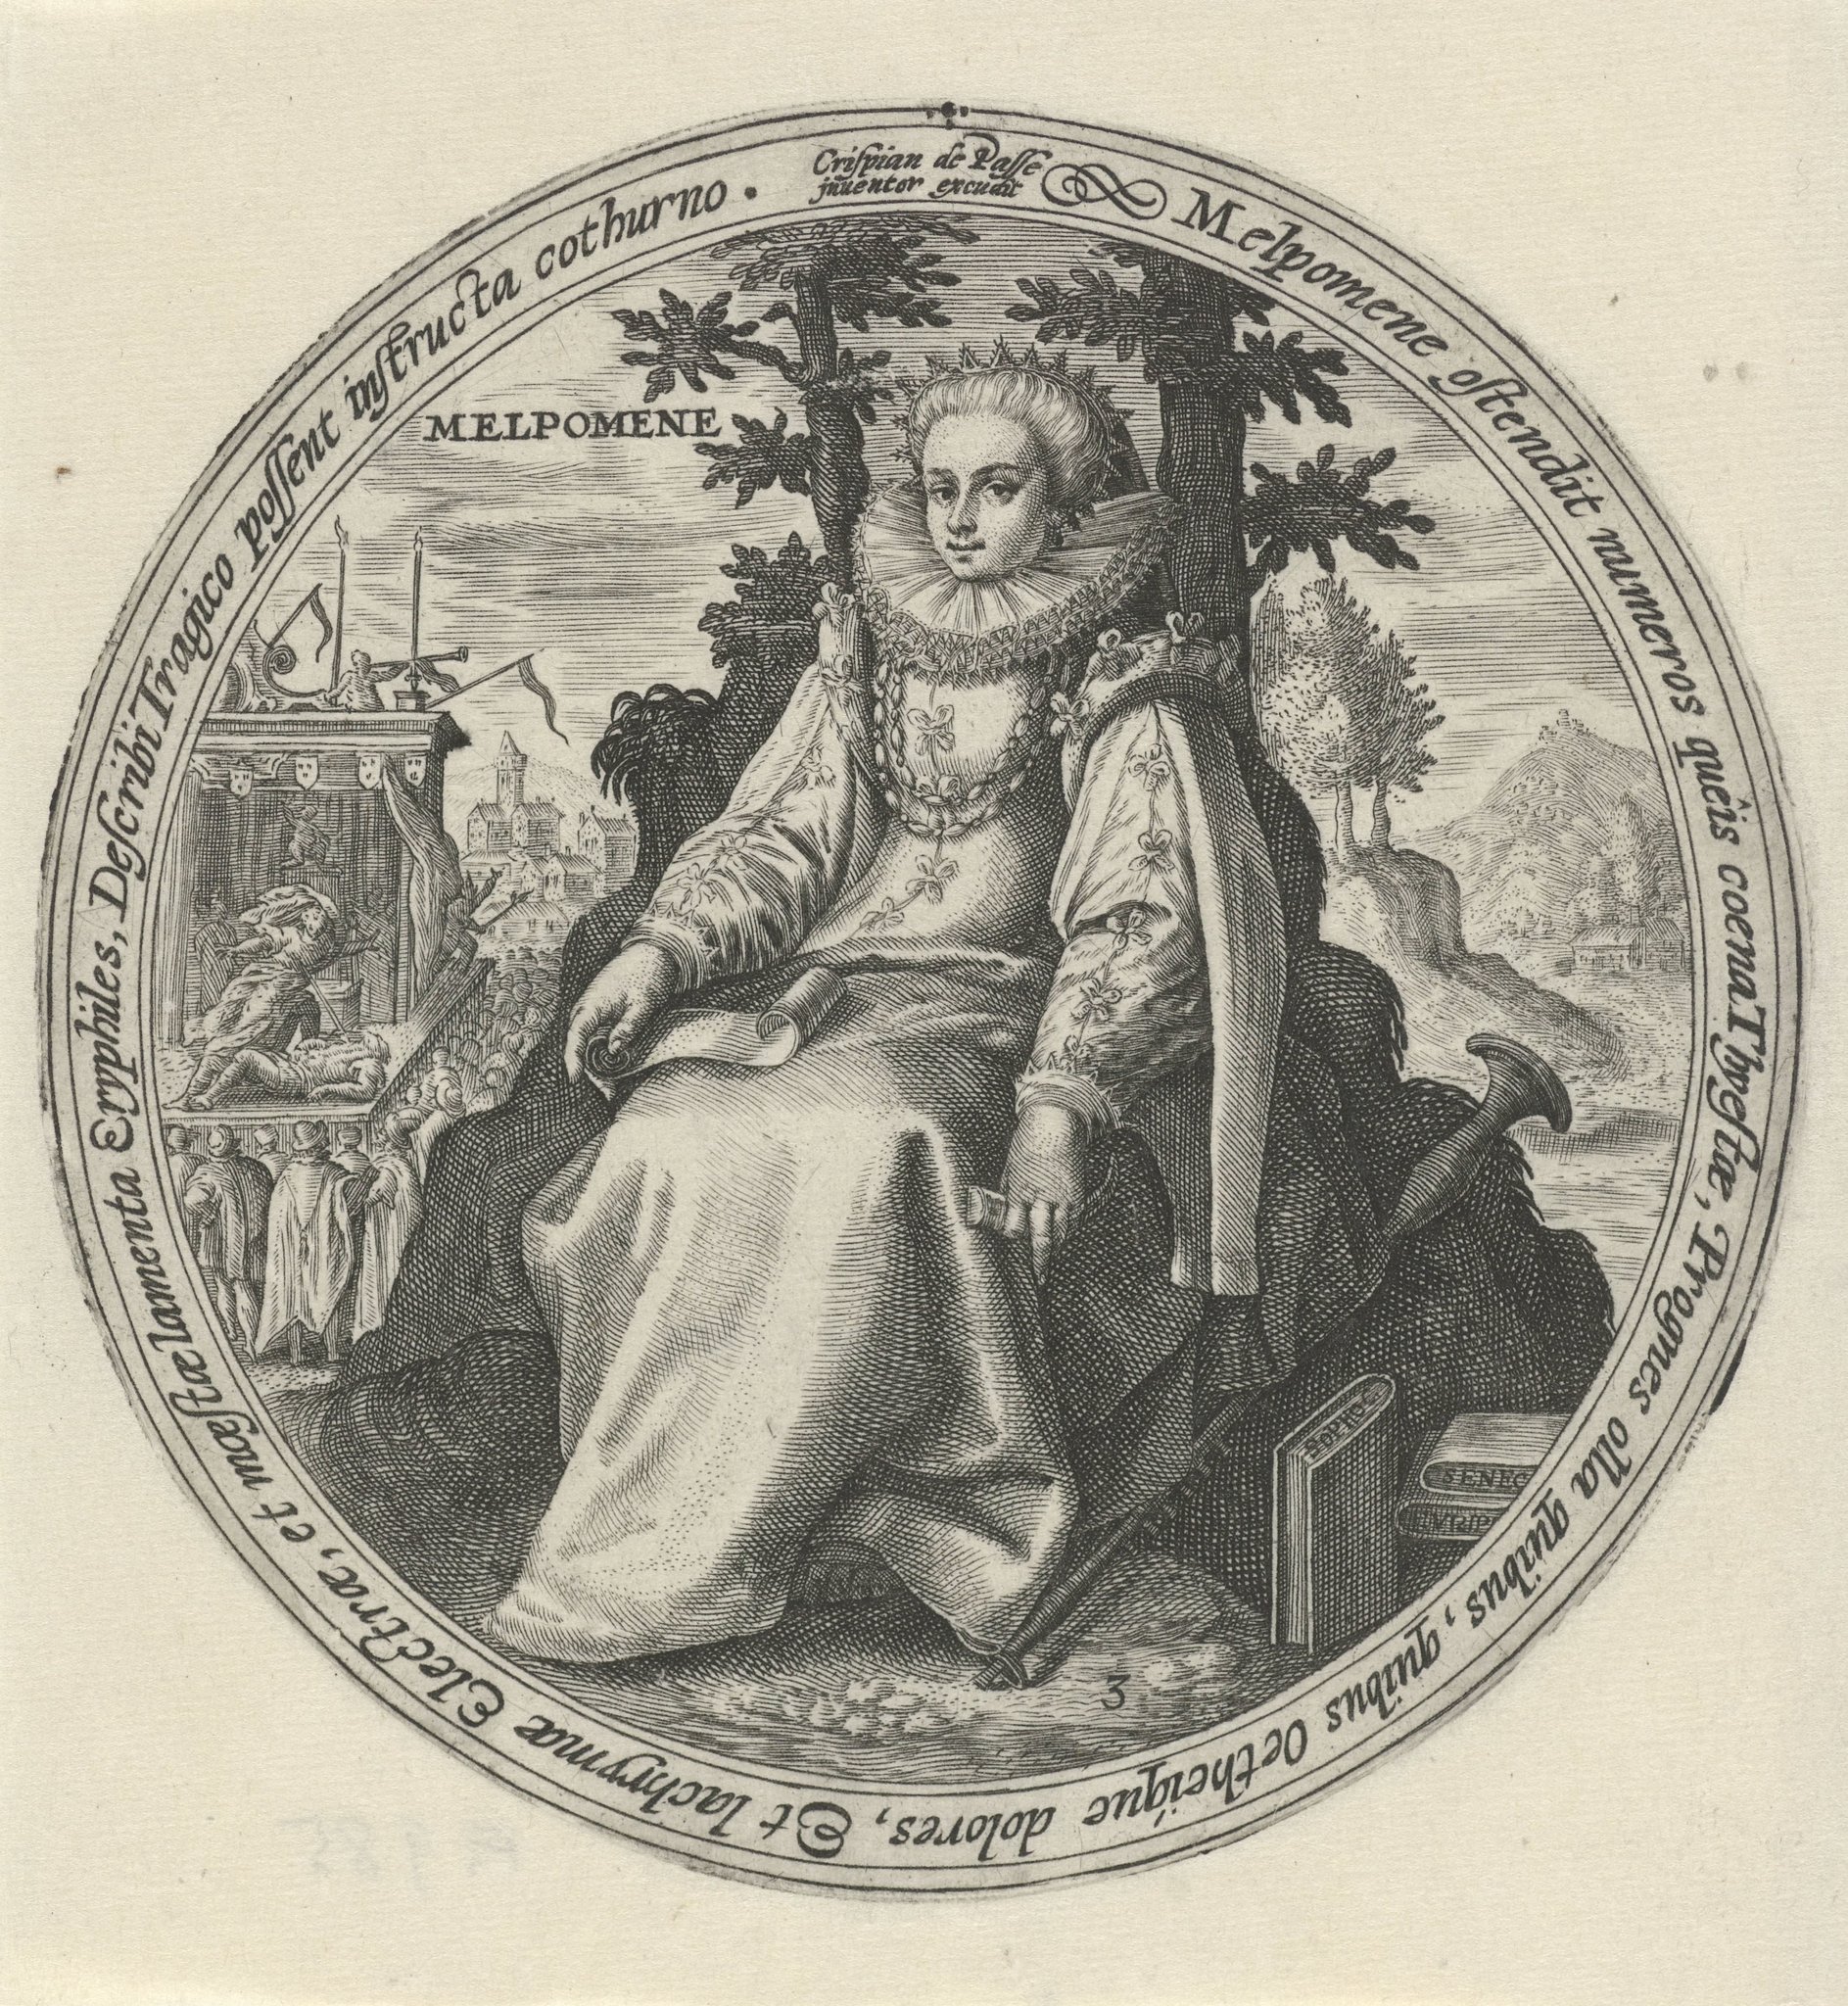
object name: print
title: De negen muzen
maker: crispijn van de passe (i)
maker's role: draughtsman, print maker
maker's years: 1564-1637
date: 1589-1611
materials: paper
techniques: engraving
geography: cologne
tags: theatre, theatrical performance, melpomene (one of the muses); 'melpomene' (ripa)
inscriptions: collector's mark: Lugt 2760, collector's mark: Lugt 2228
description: Landschap met Melpomene, de muze van het treurspel, met een lege dolkschede en een papier in haar handen. Op de achtergrond wordt op een podium een toneelspel opgevoerd. Derde prent uit een serie met muzen.